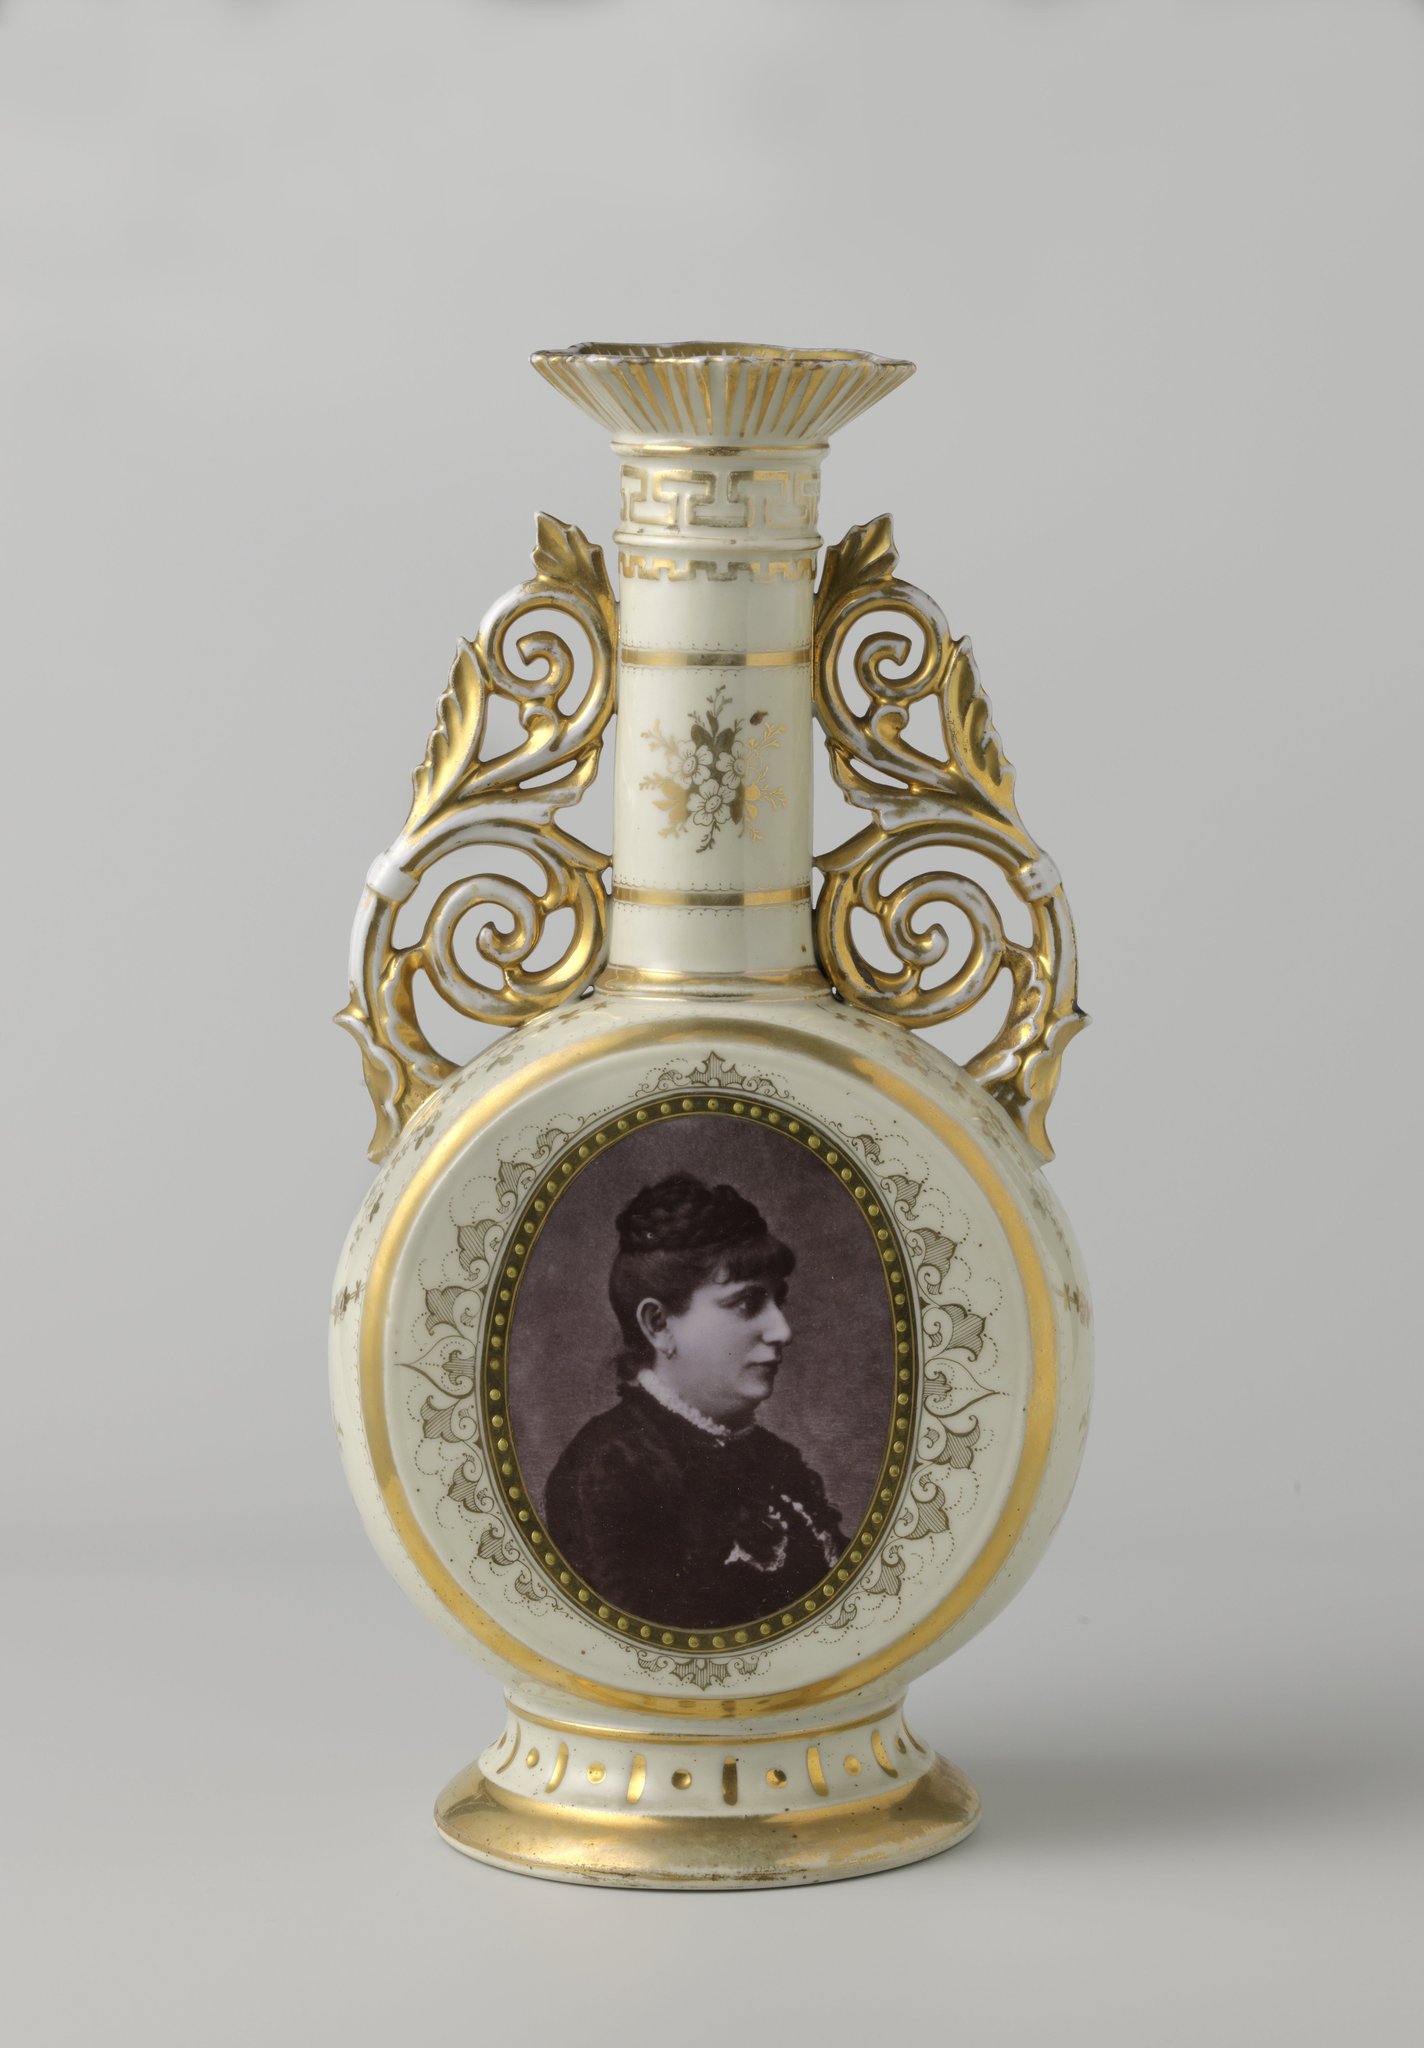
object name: object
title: Vaas met fotografische portretten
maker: Anonymous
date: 1400-1950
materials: ceramic